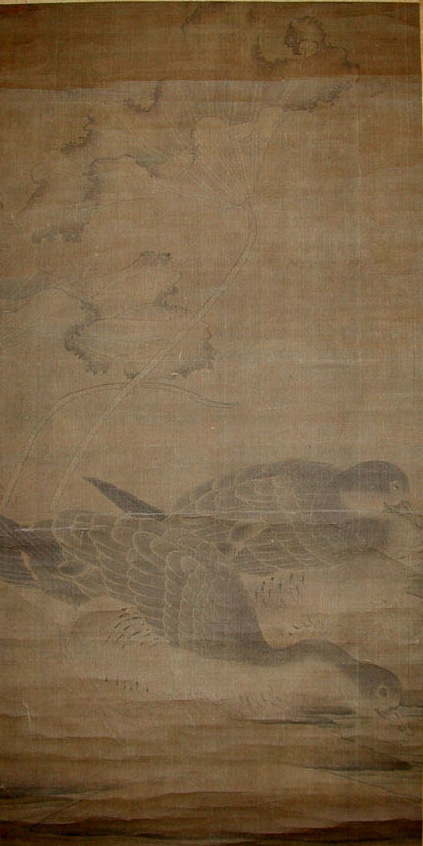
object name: hanging scroll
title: Geese and Lotus Leaves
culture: chinese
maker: unidentified artist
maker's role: artist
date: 1368-1911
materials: ink, silk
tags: geese